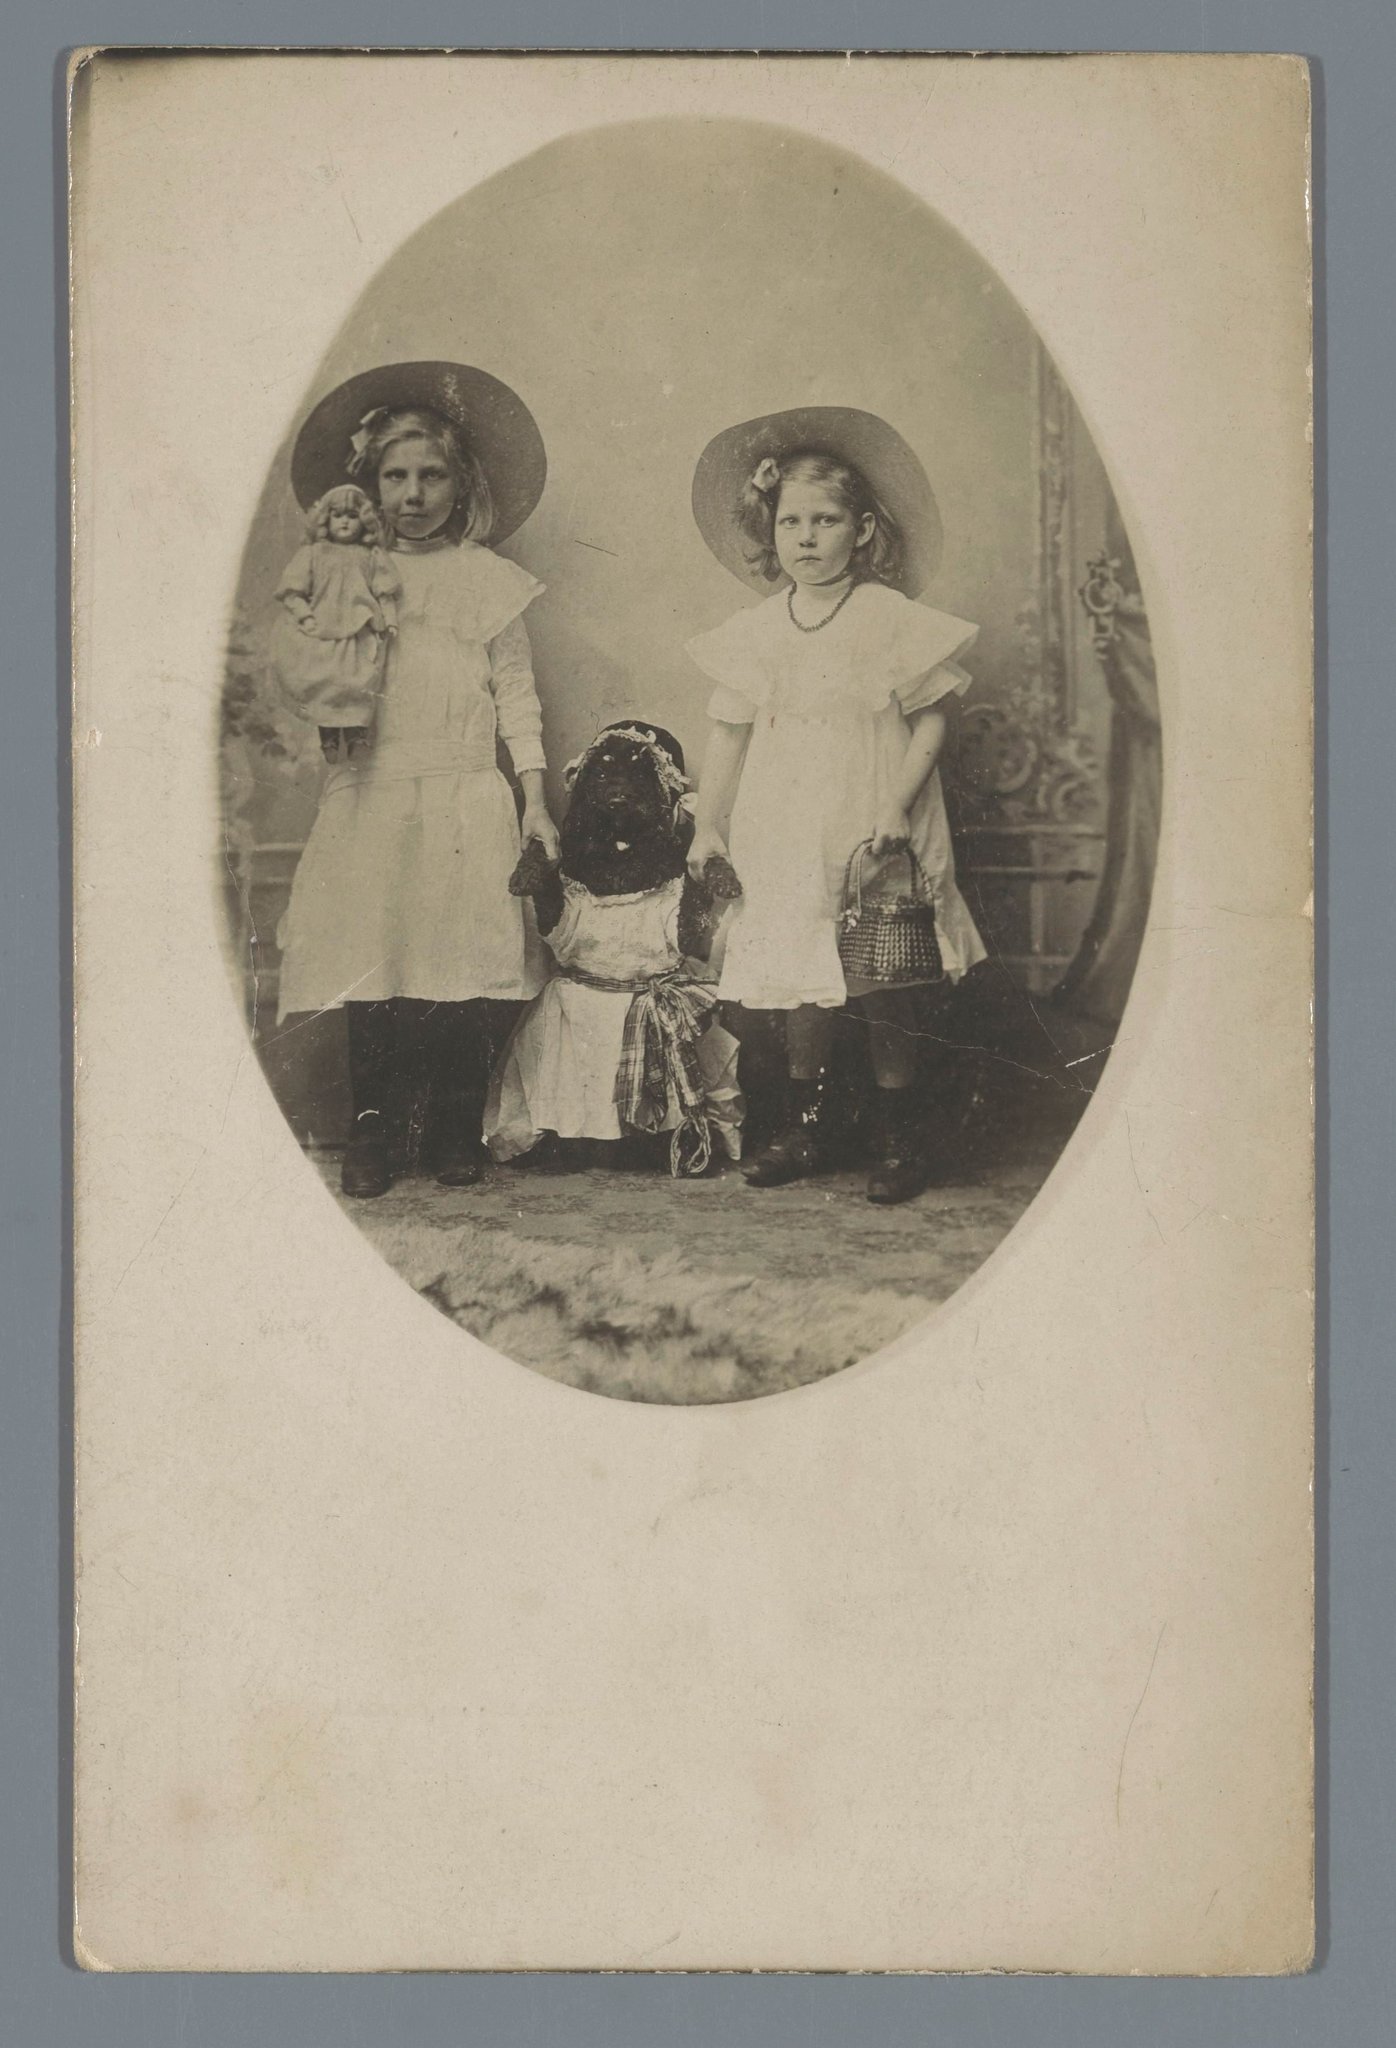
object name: ansichtkaart, prentbriefkaart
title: Portret van twee onbekende meisjes met een verklede hond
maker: Anonymous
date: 1907-1915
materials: photographic support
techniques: gelatin silver print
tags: girl (child between toddler and youth), (playing with) dolls, dog